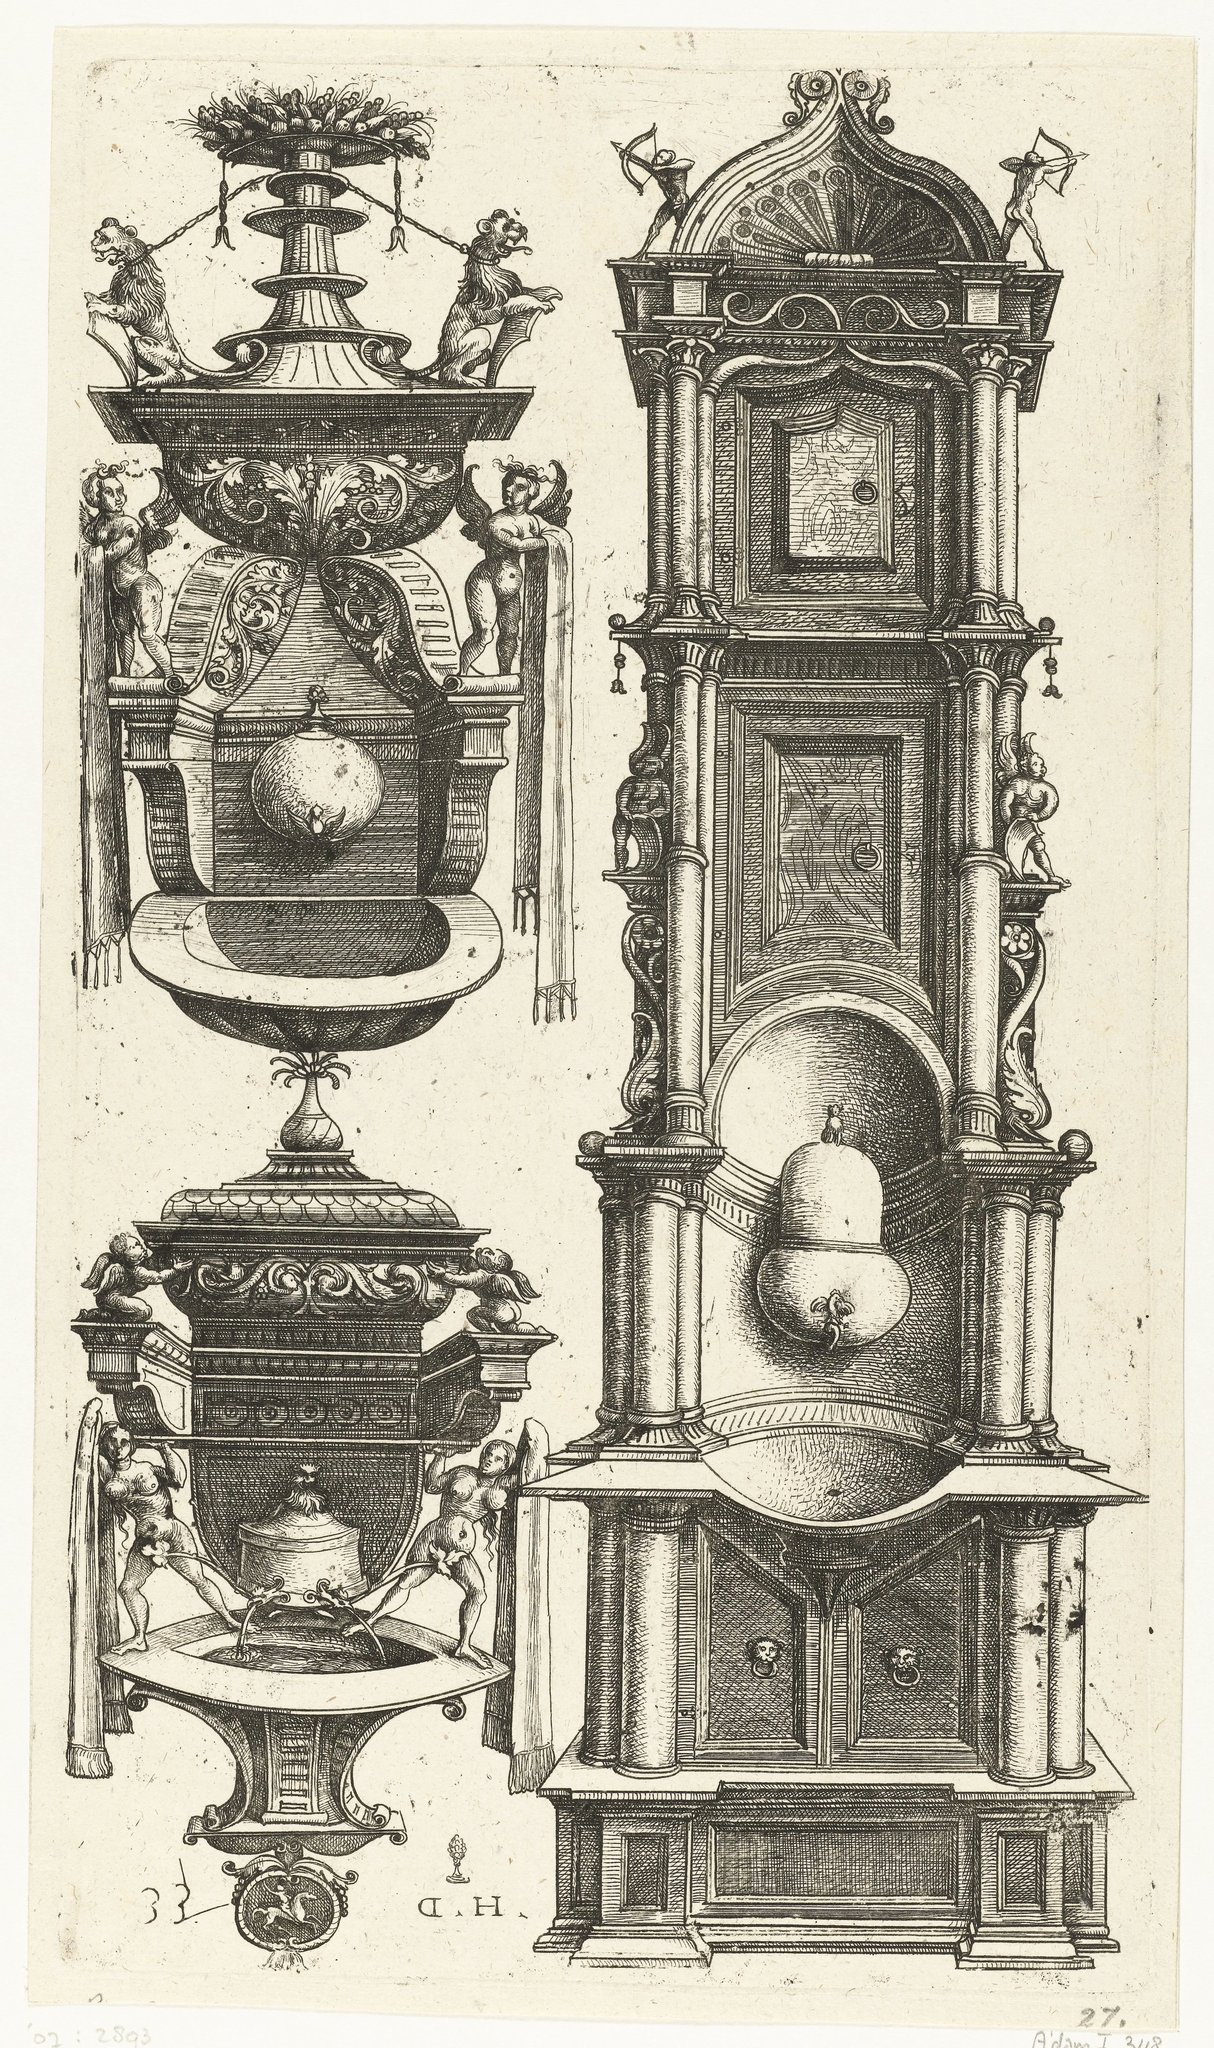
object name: ornament print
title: Blad met drie ontwerpen voor wastafels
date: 1480-1536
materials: paper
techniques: etching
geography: germany